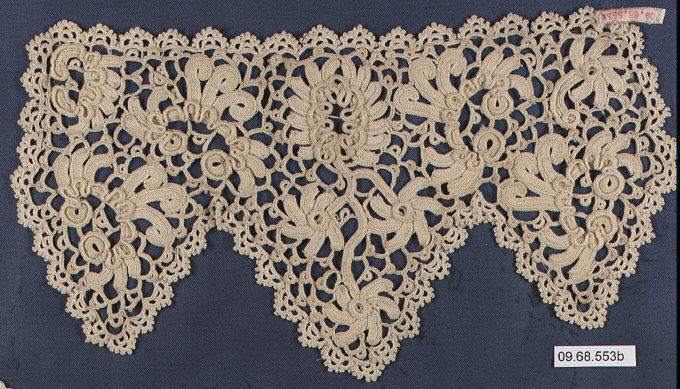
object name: specimen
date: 1801-1900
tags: flowers